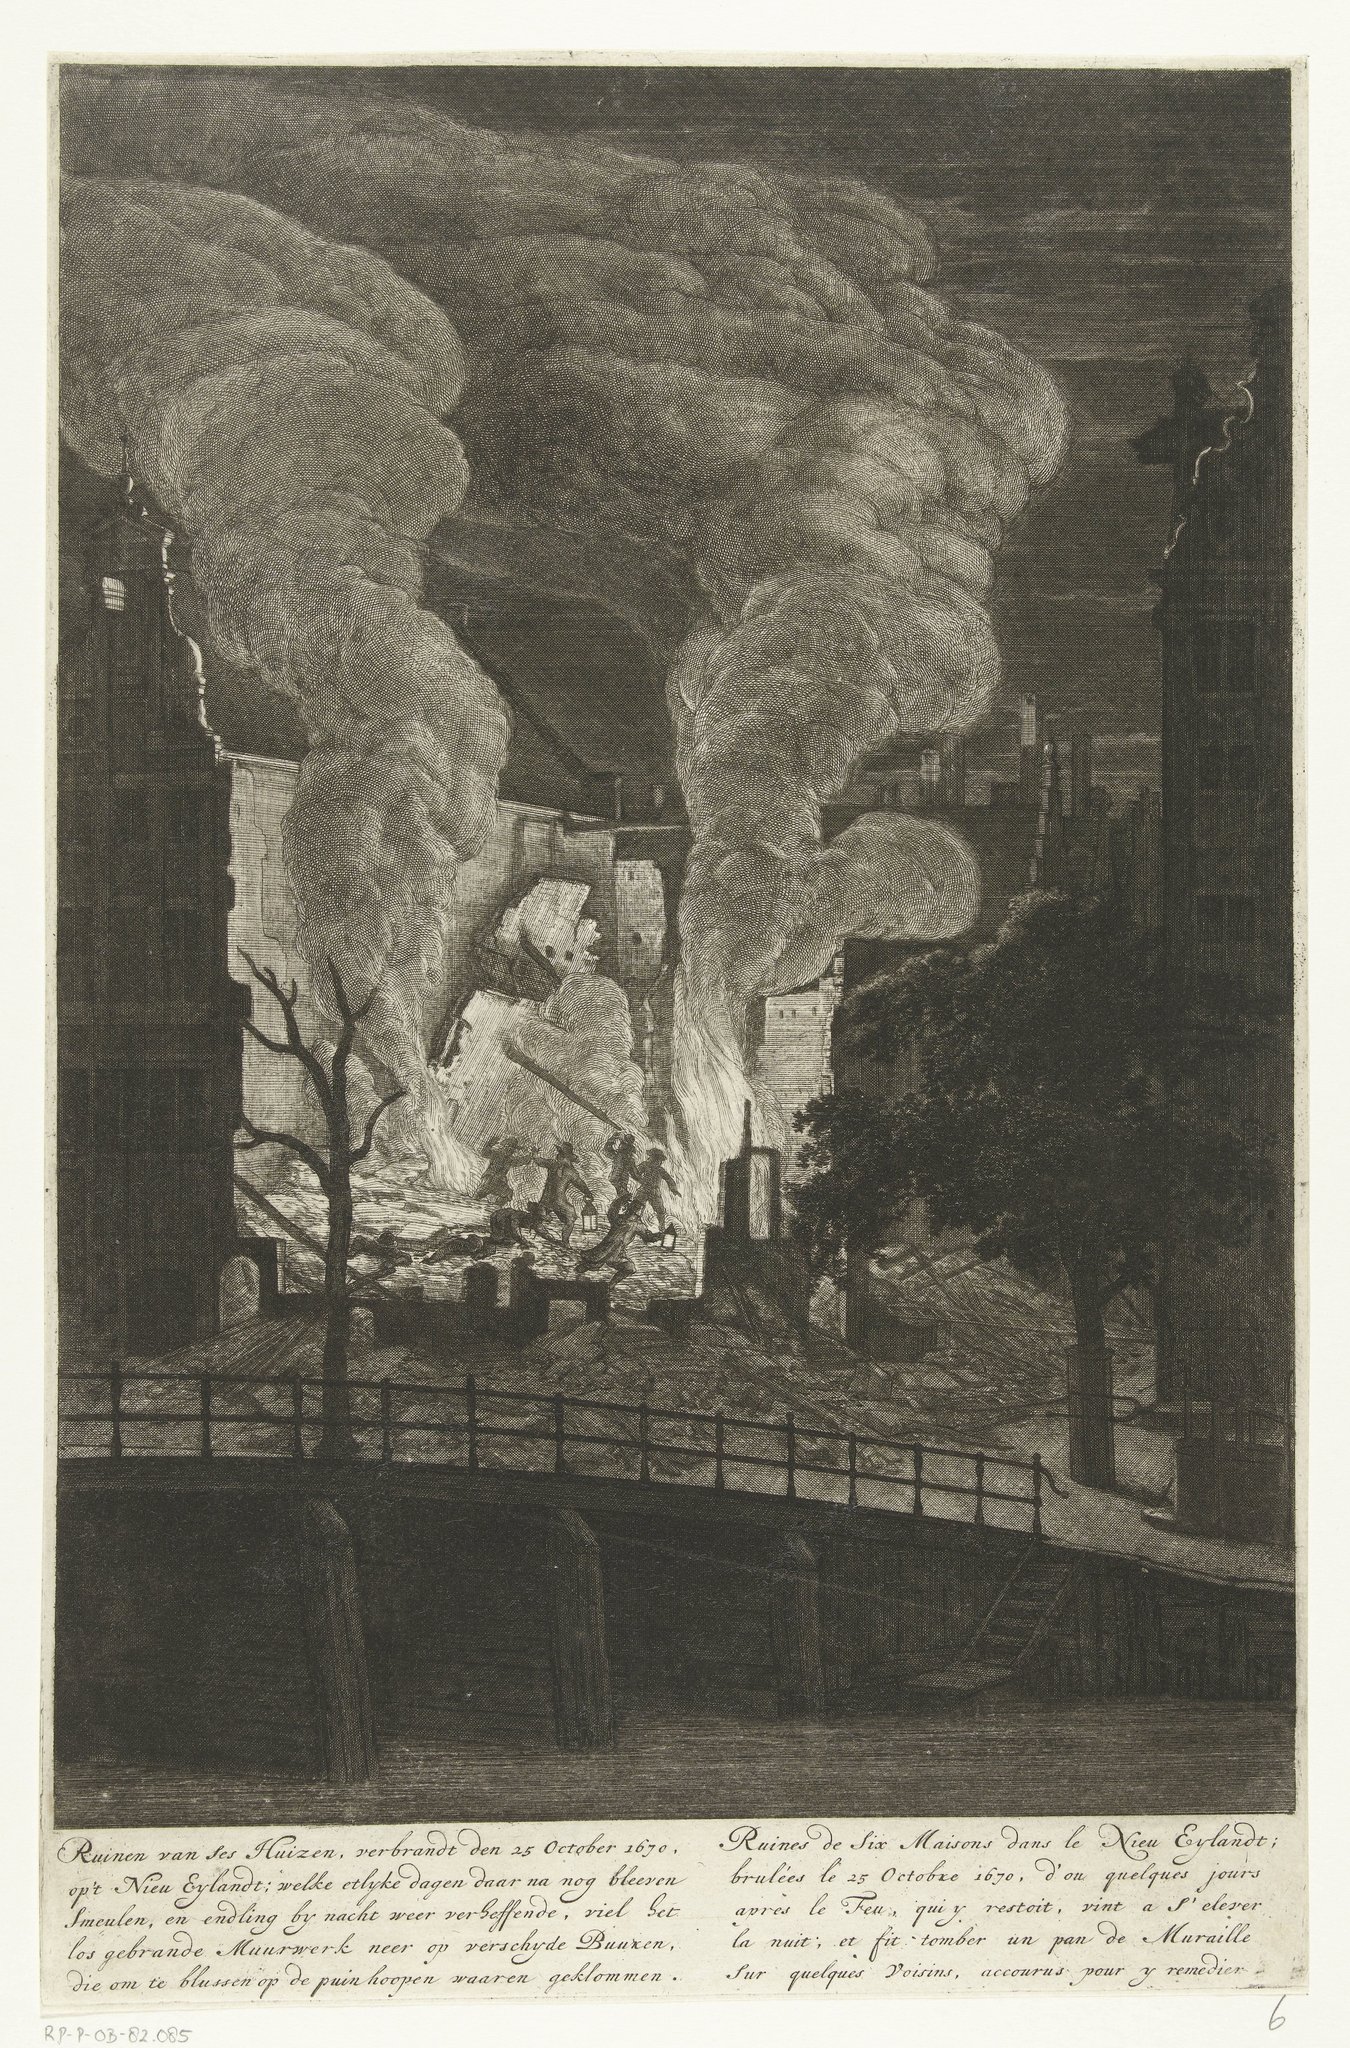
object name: print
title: Ruinen van ses huizen, verbrandt den 25 october 1670, op 't Nieu Eylandt (…) / Ruines de six maisons dans le Nieu Eylandt; brulées le 25 octobre 1670 (…)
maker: jan van der heyden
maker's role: draughtsman, painter, print maker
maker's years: 1637-1712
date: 1690-1735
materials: paper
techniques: engraving, etching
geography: amsterdam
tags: painter, print maker, draughtsman, jan van der heyden, on fire, ablaze, fire-fighting, fire-extinguishing equipment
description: Prent ook gebruikt in: Heyden, Jan van der. Beschryving der nieuwlyks uitgevonden en geoctrojeerde slang-brand-spuiten en haare wyze van brand-blussen, tegenwoordig binnen Amsterdam in gebruik zijnde (…). 1e druk. Amsterdam: Jan Rieuwertsz. (II), 1690. En in: Heyden, Jan van der. Beschryving der nieuwlyks uitgevonden en geoctrojeerde slang-brand-spuiten en haare wyze van brand-blussen, tegenwoordig binnen Amsterdam in gebruik zijnde (…). 2e druk. Amsterdam: erfgenamen Jan van der Heyden, 1735.